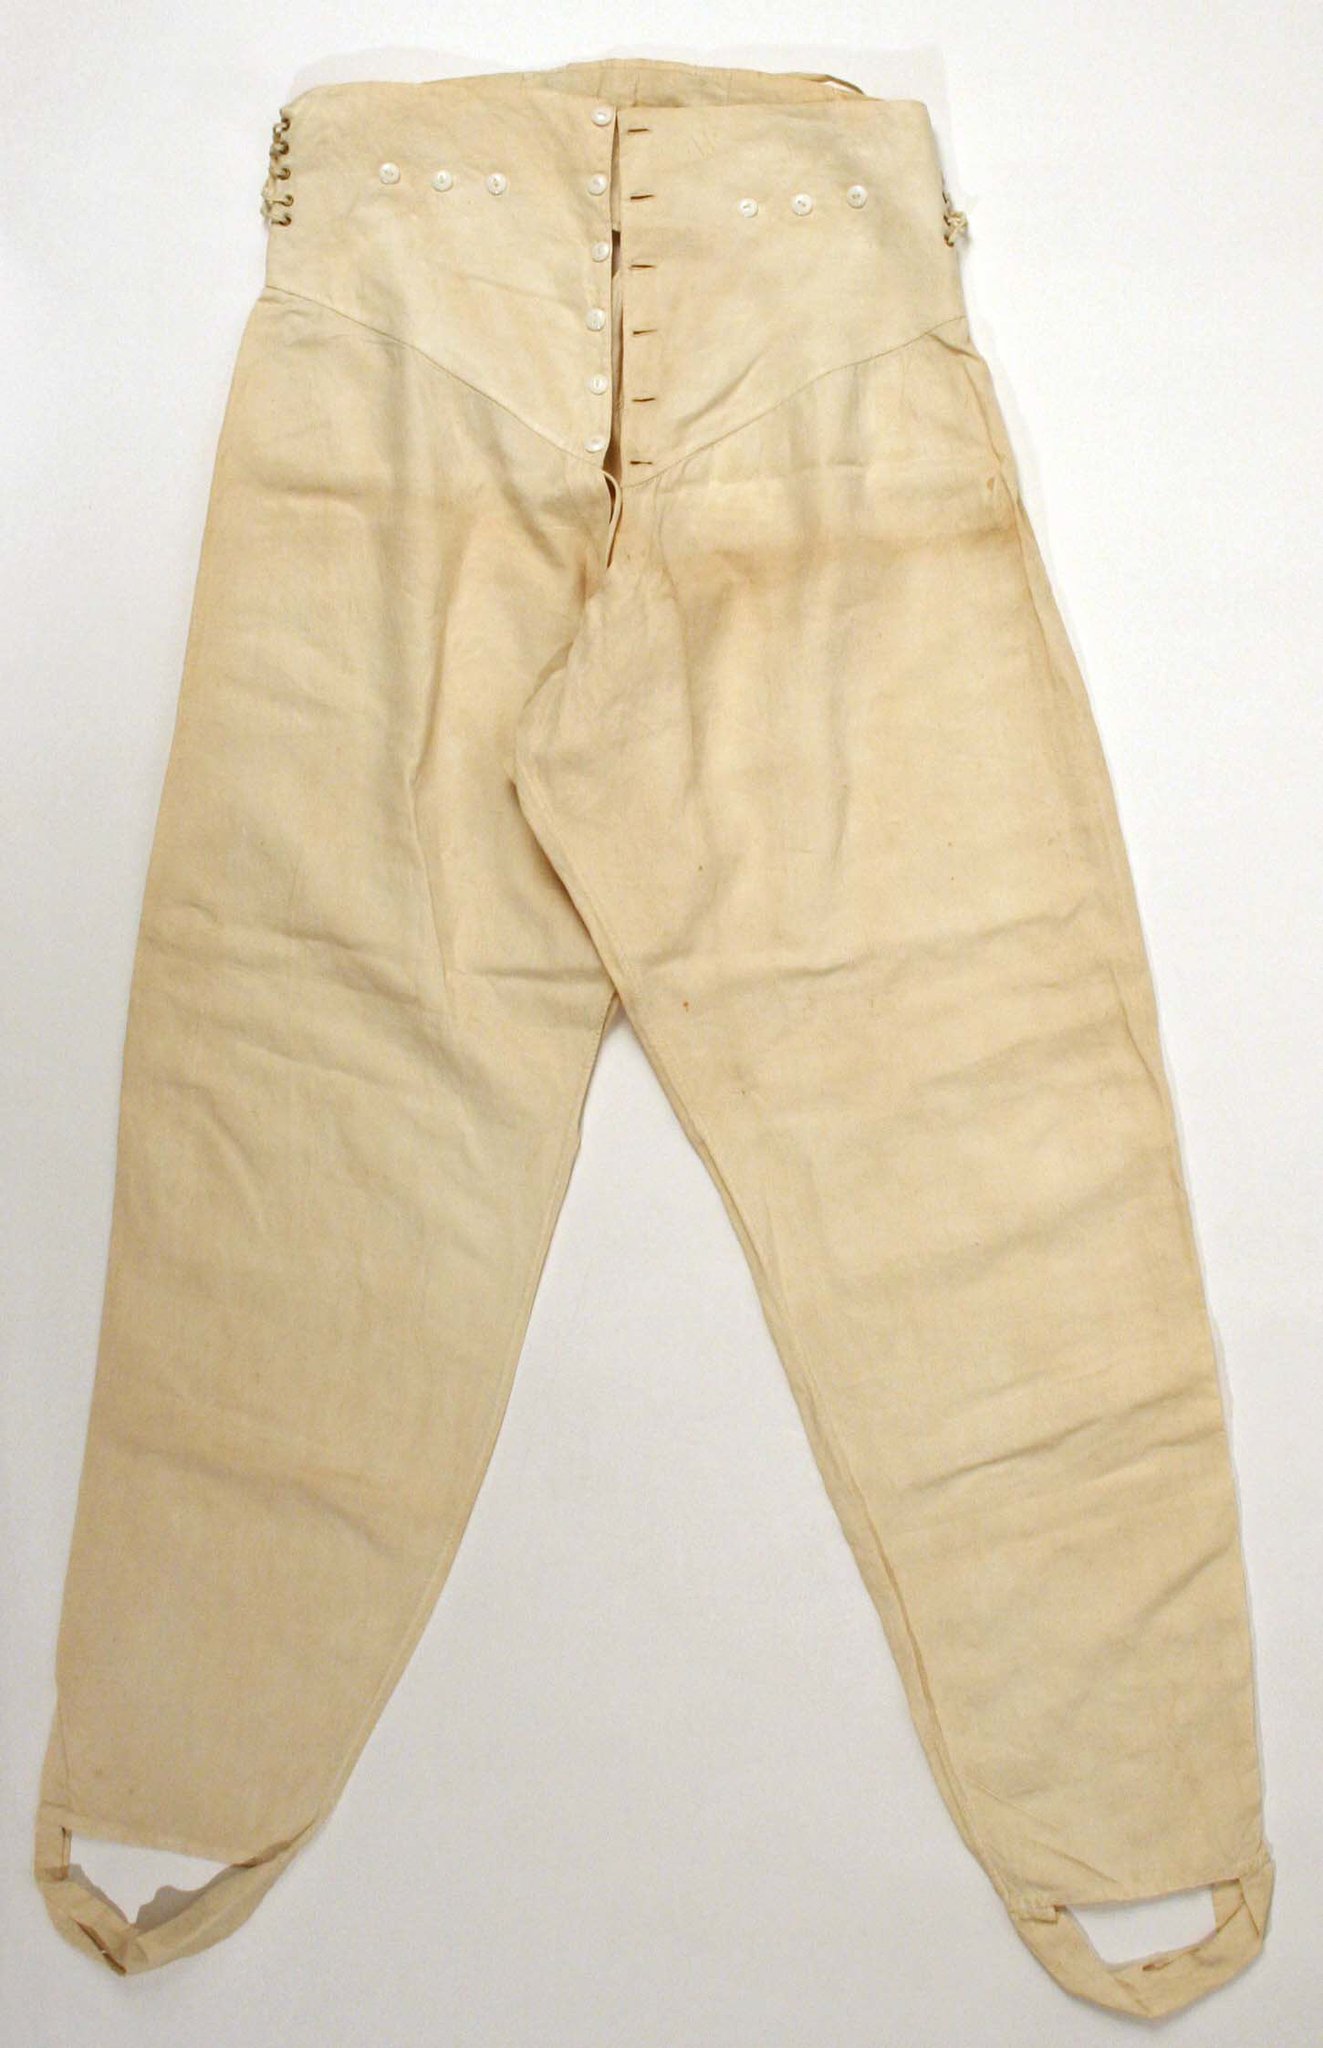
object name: trouser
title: Trousers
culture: american or european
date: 1820-1830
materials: linen